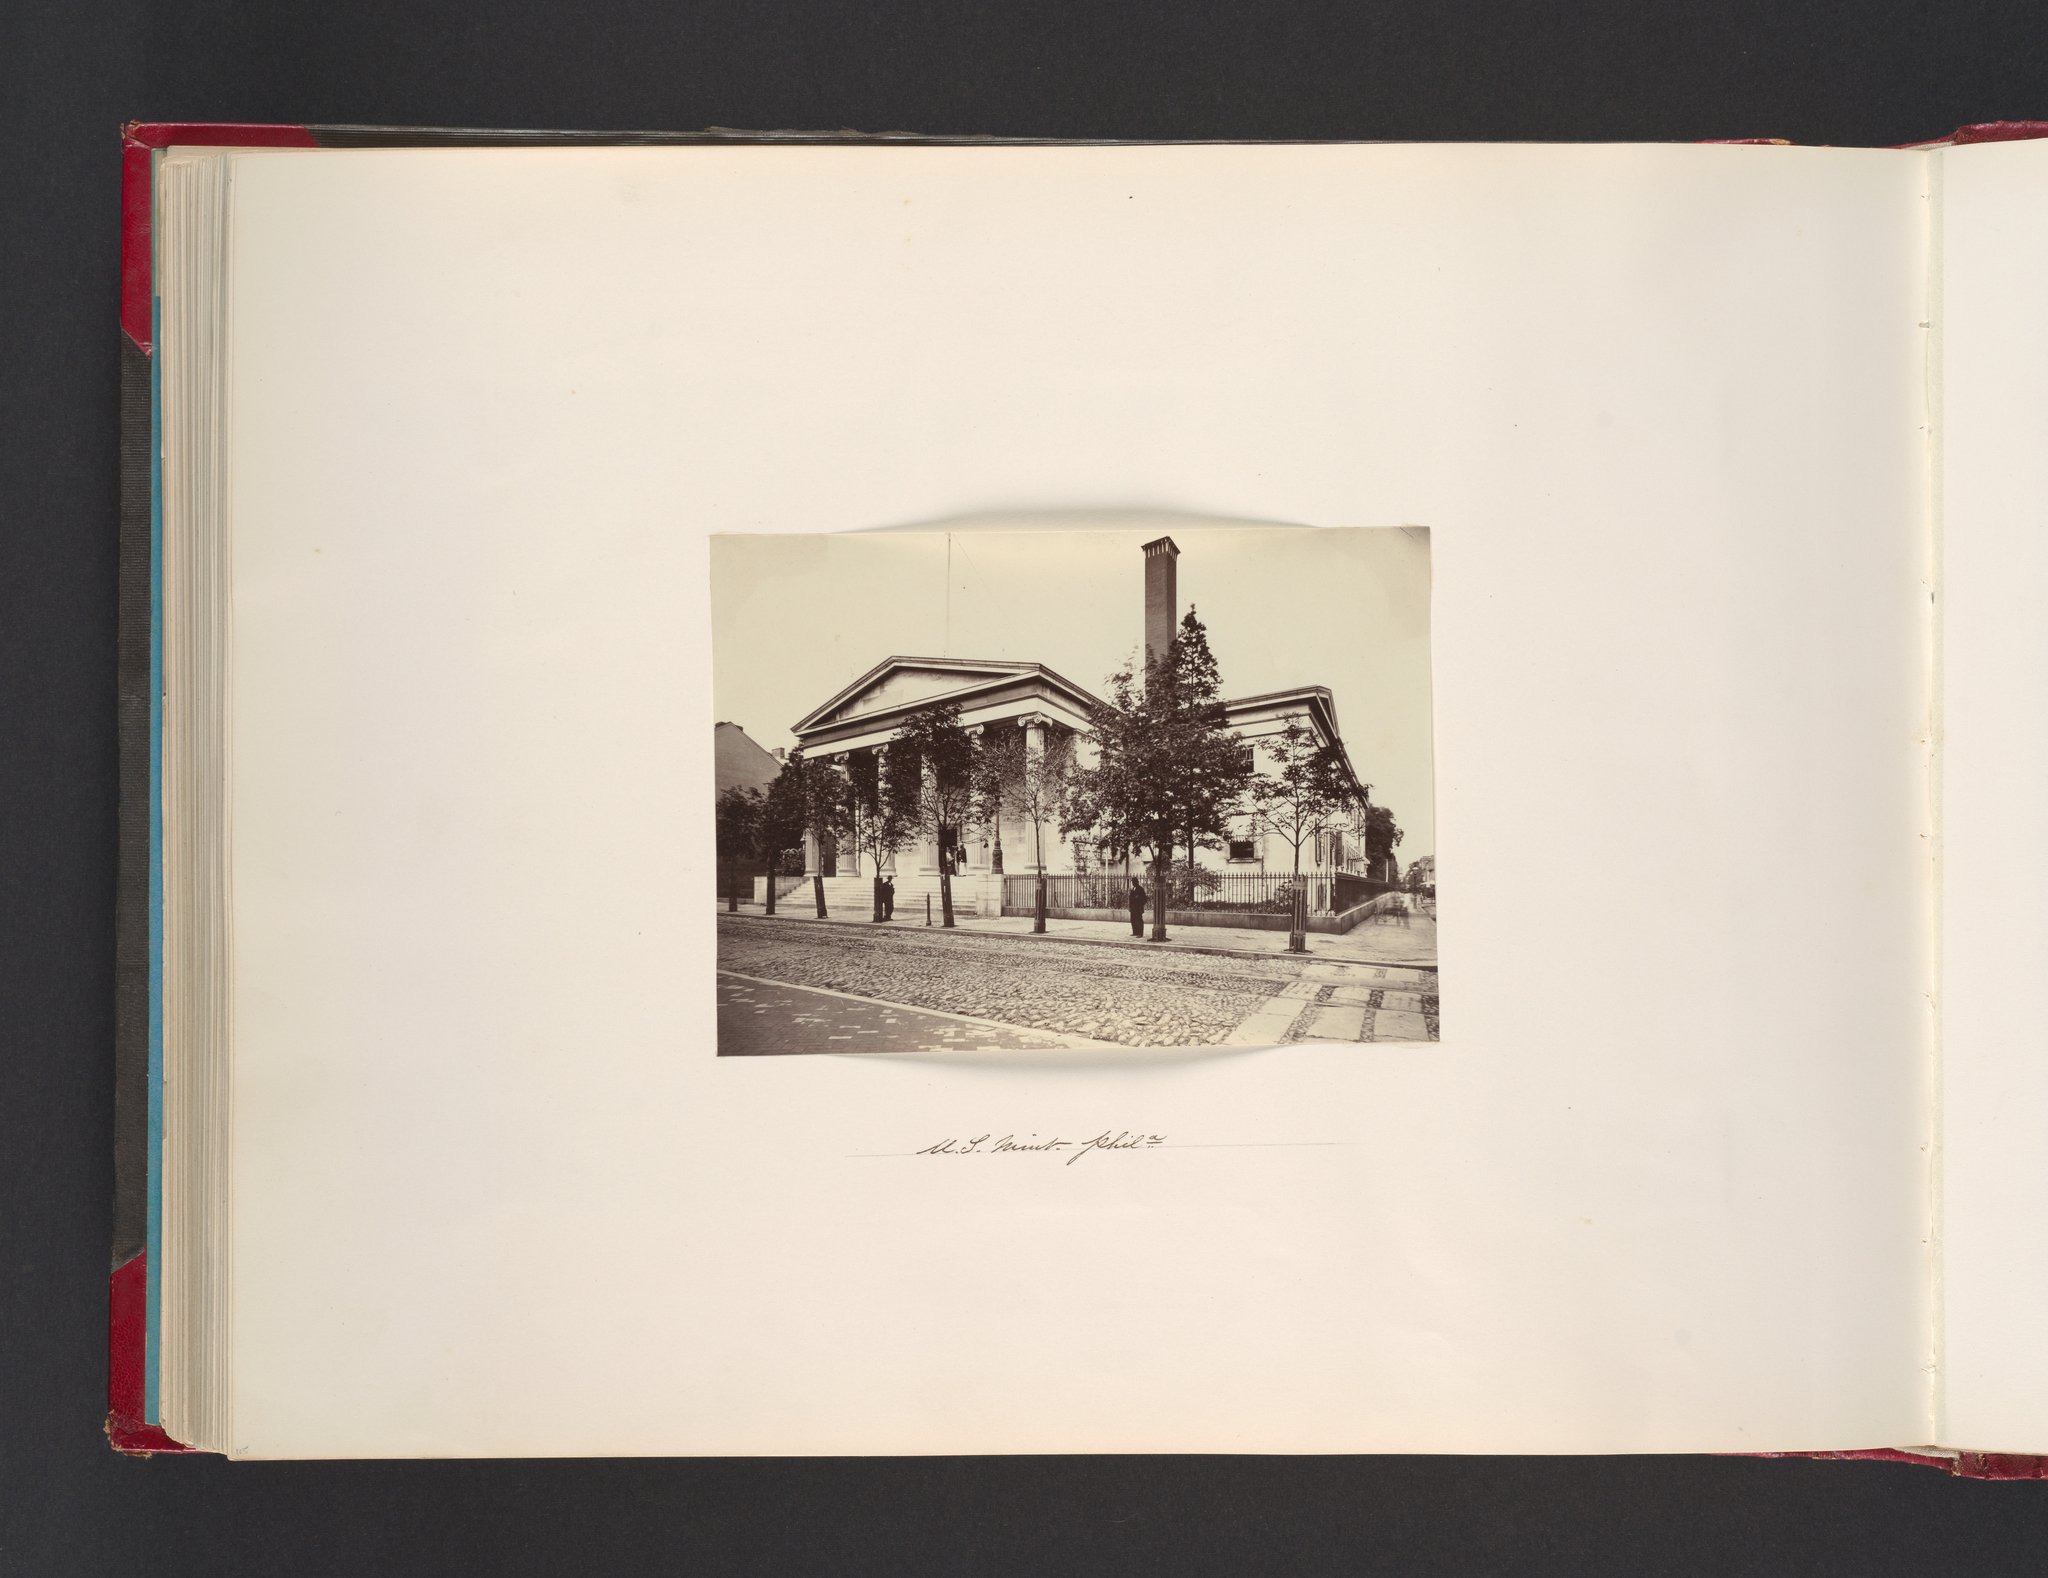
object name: photograph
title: [U.S.Mint, Philadelphia]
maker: john thomson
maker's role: artist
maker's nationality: british, scottish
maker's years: 1837-1921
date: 1865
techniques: albumen silver print, glass negative